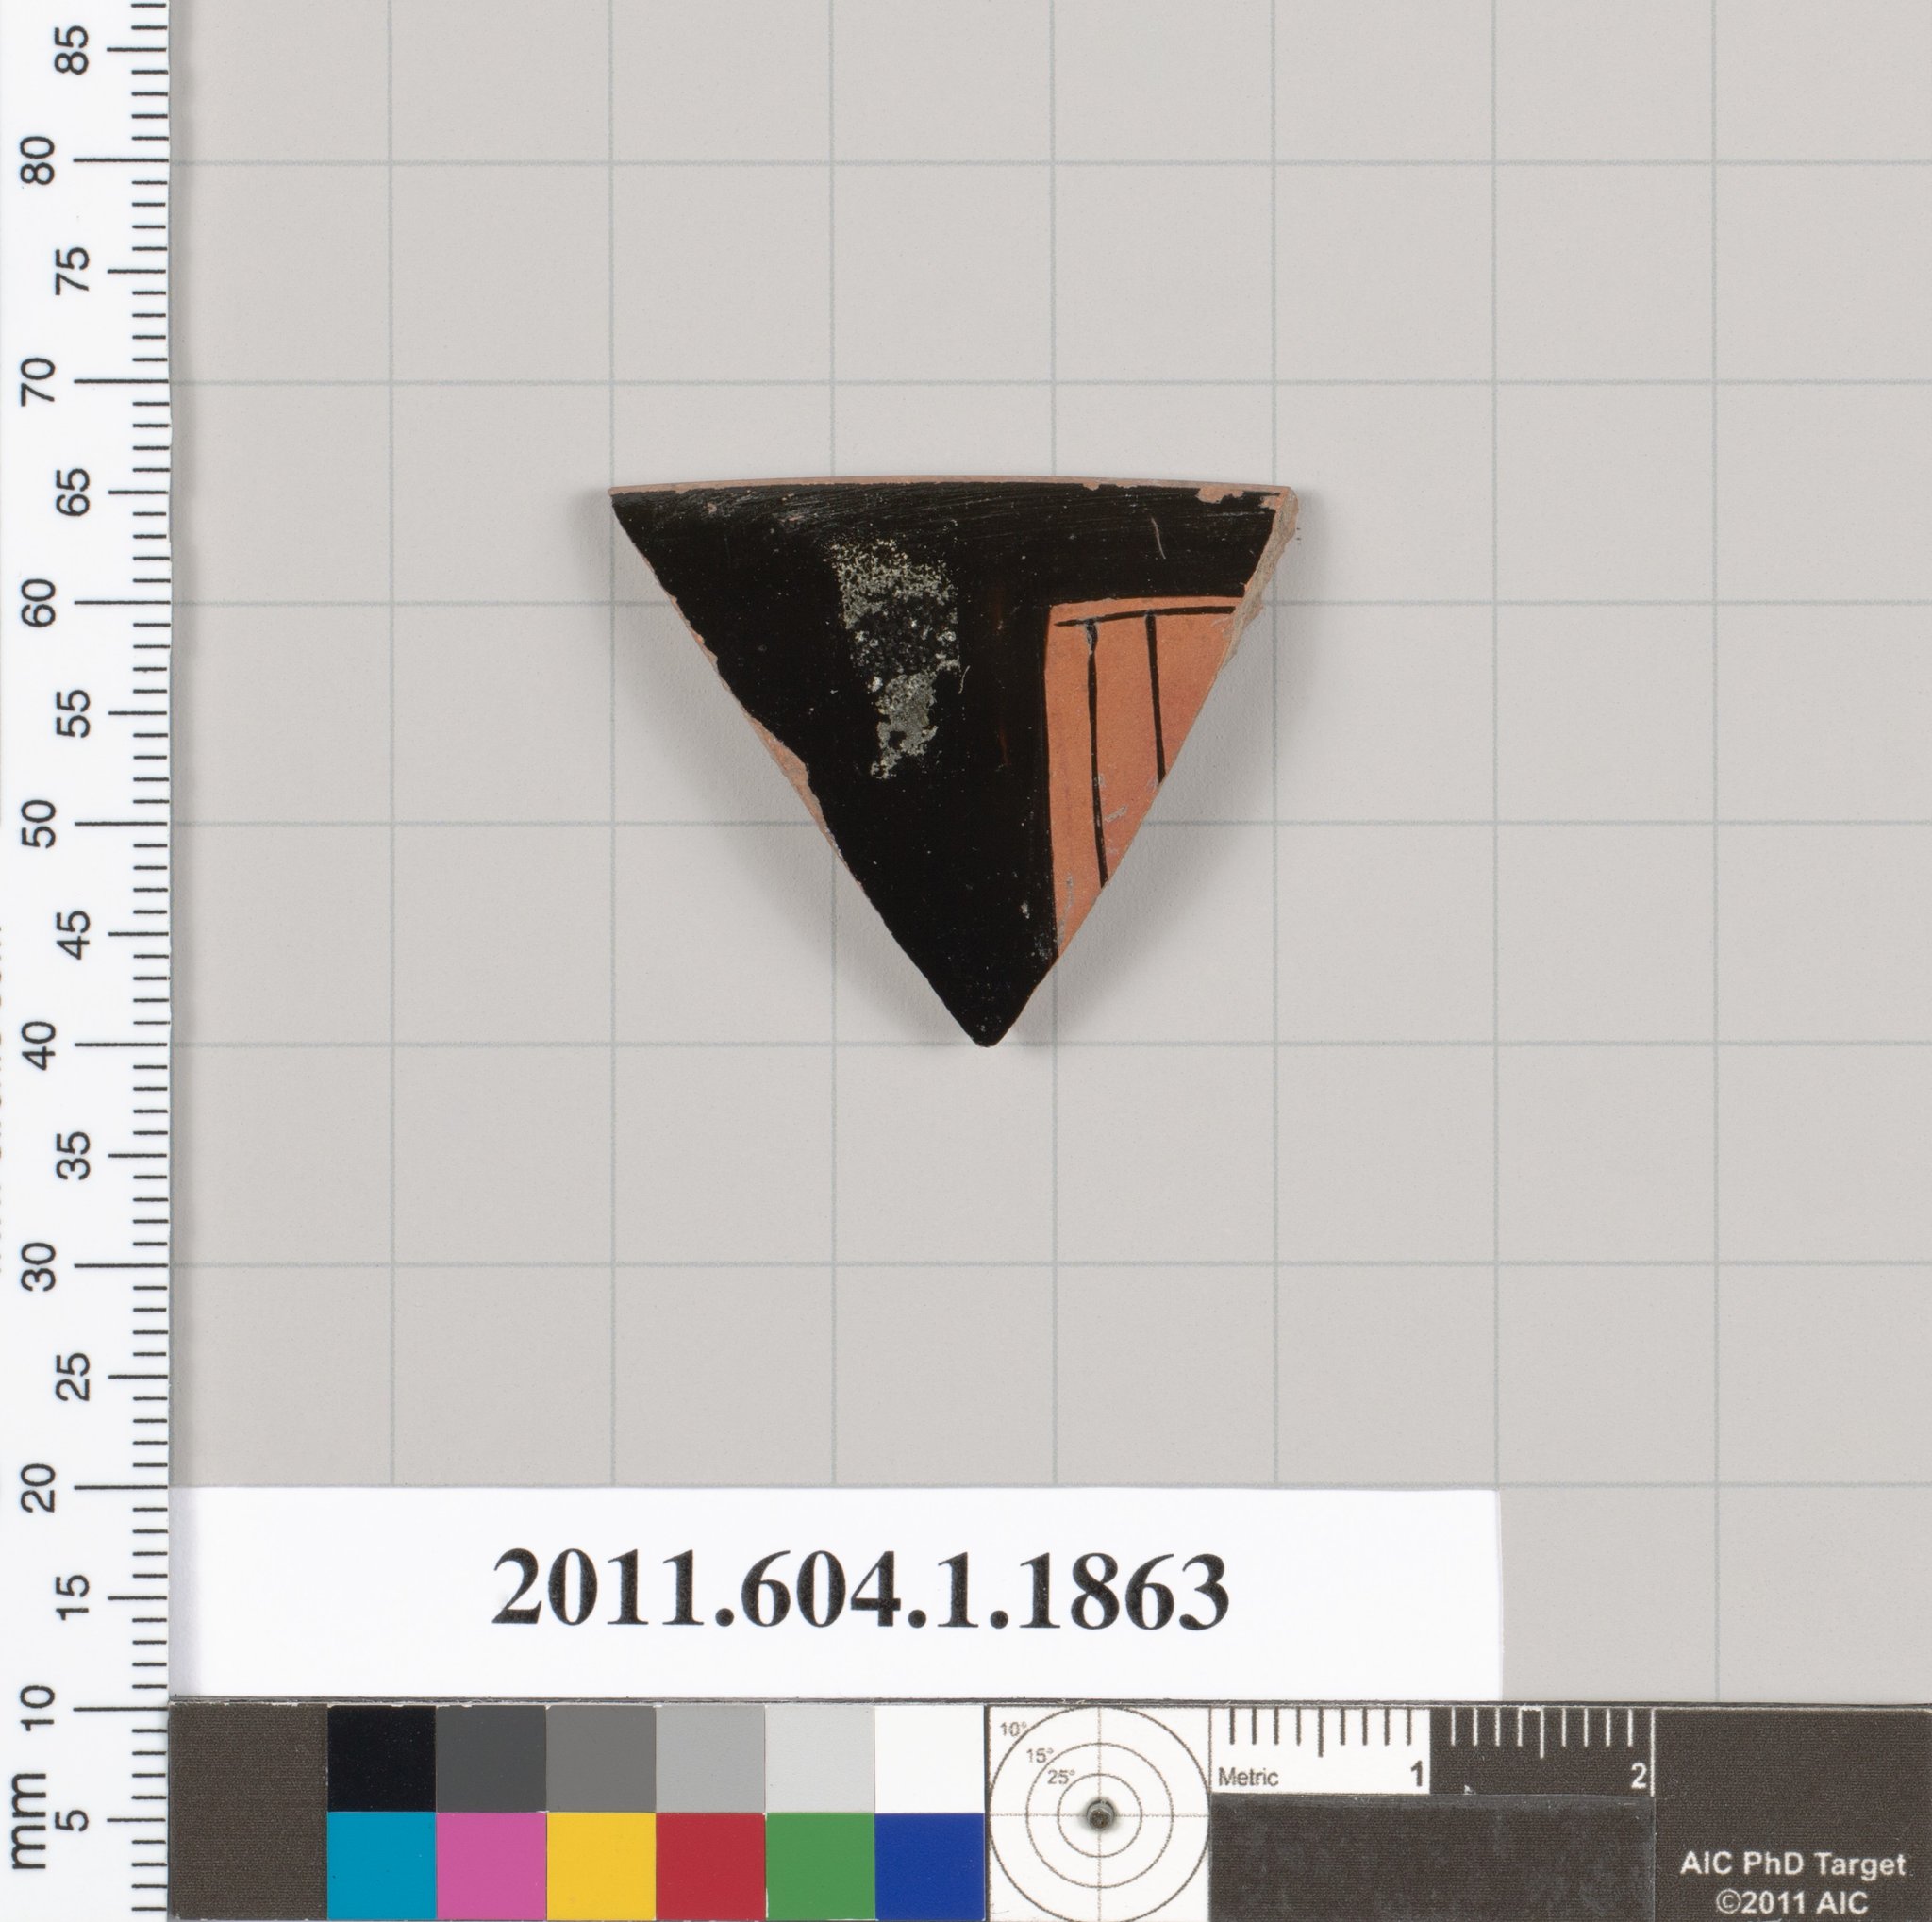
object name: kylix fragment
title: Terracotta rim fragment of a kylix (drinking cup)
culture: greek, attic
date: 475-451 BCE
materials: terracotta